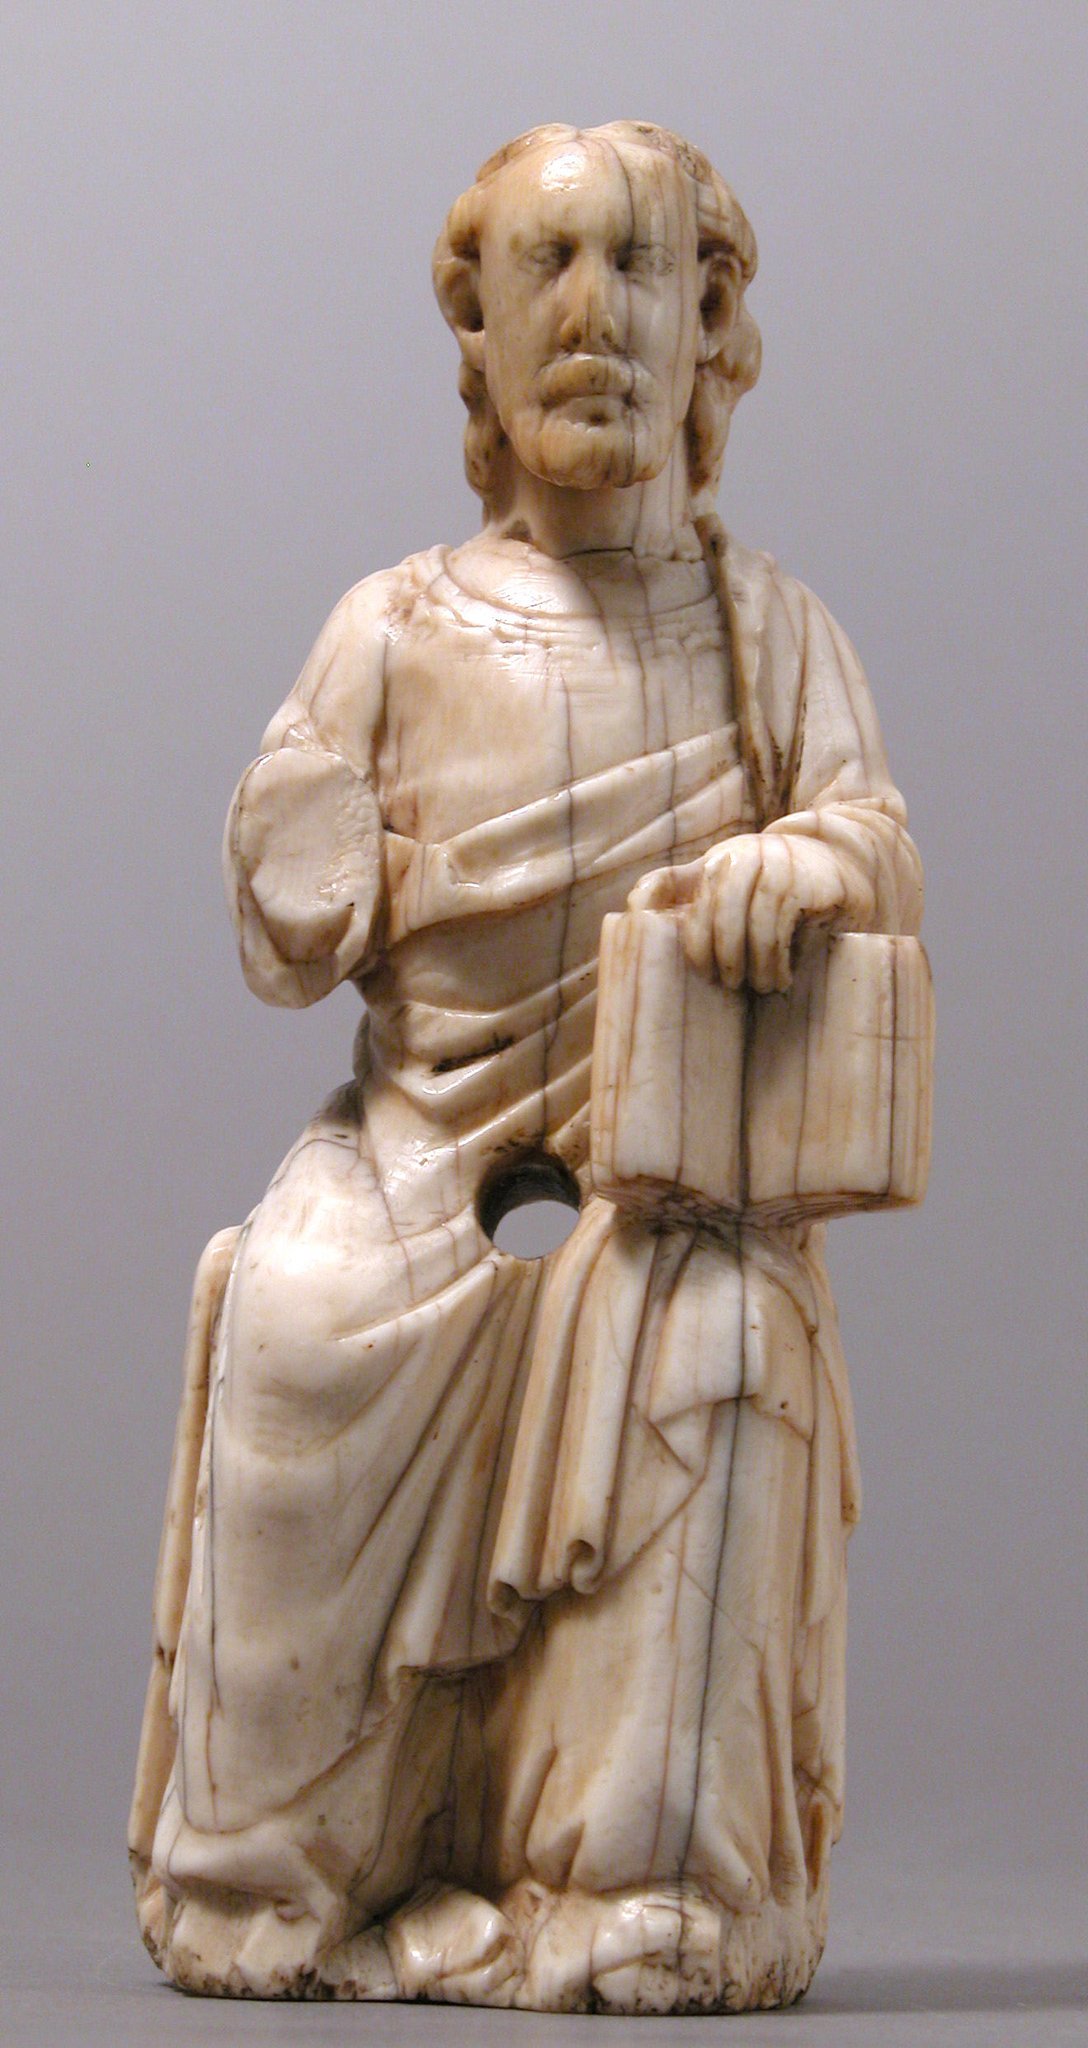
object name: relief statue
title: Christ Enthroned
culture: french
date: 1230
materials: ivory